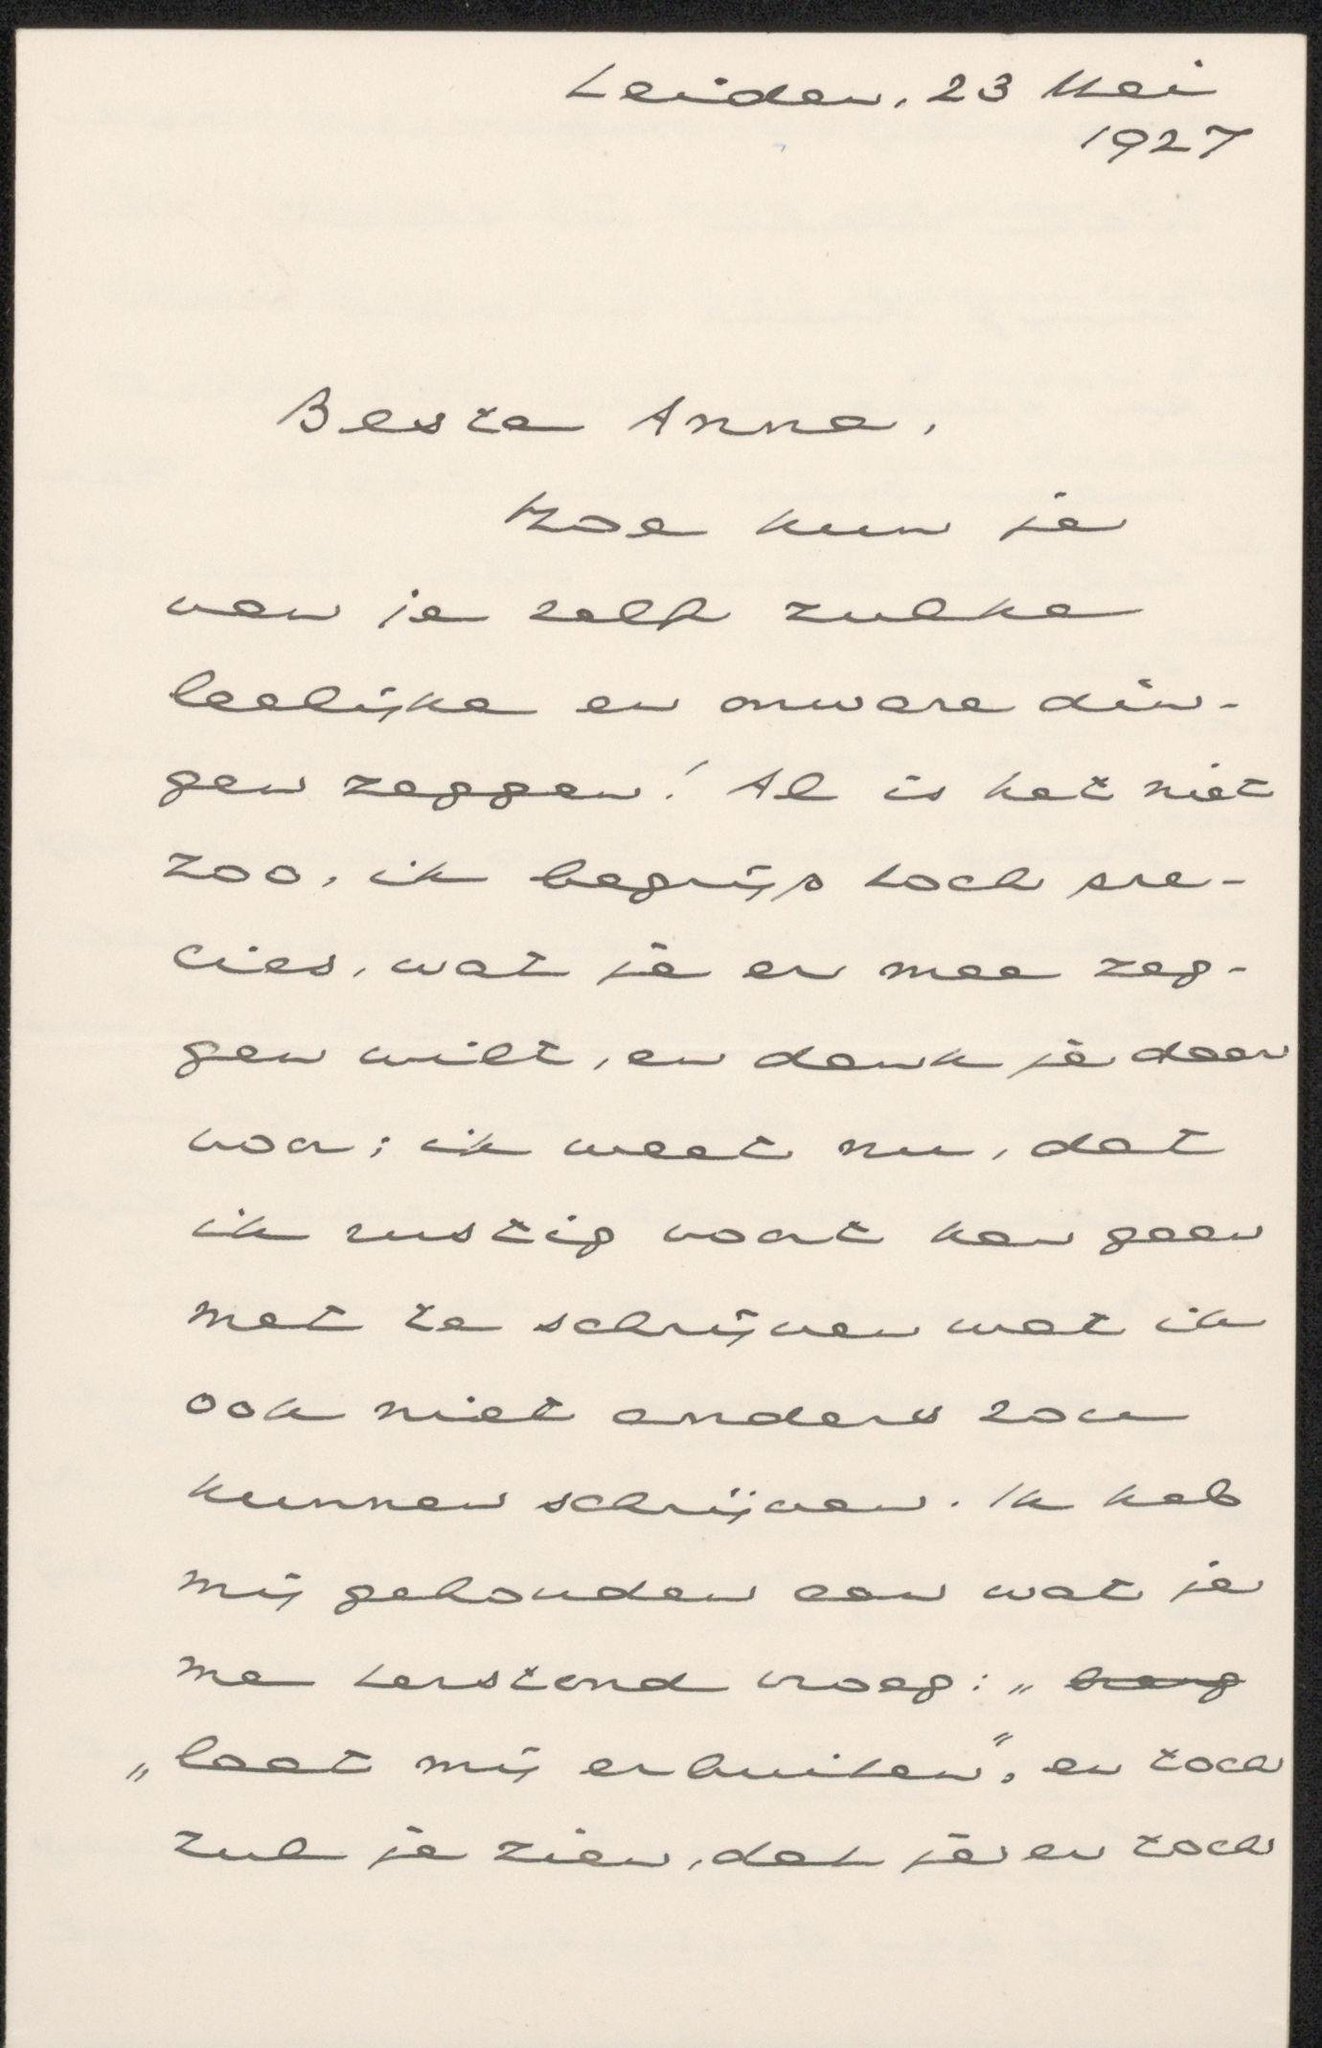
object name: letter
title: Brief aan Anna Dorothea Dirks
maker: johan huizinga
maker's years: 1872-1945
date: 1927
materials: ink, paper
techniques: pen, writing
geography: leiden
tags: printer, artist, anna dorothea dirks, haarlem, publisher, hermanus diedericus tjeenk willink (1843-1917), the graphic arts, illustration ~ printed matter, book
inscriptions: collector's mark: ‘RPK’, watermark